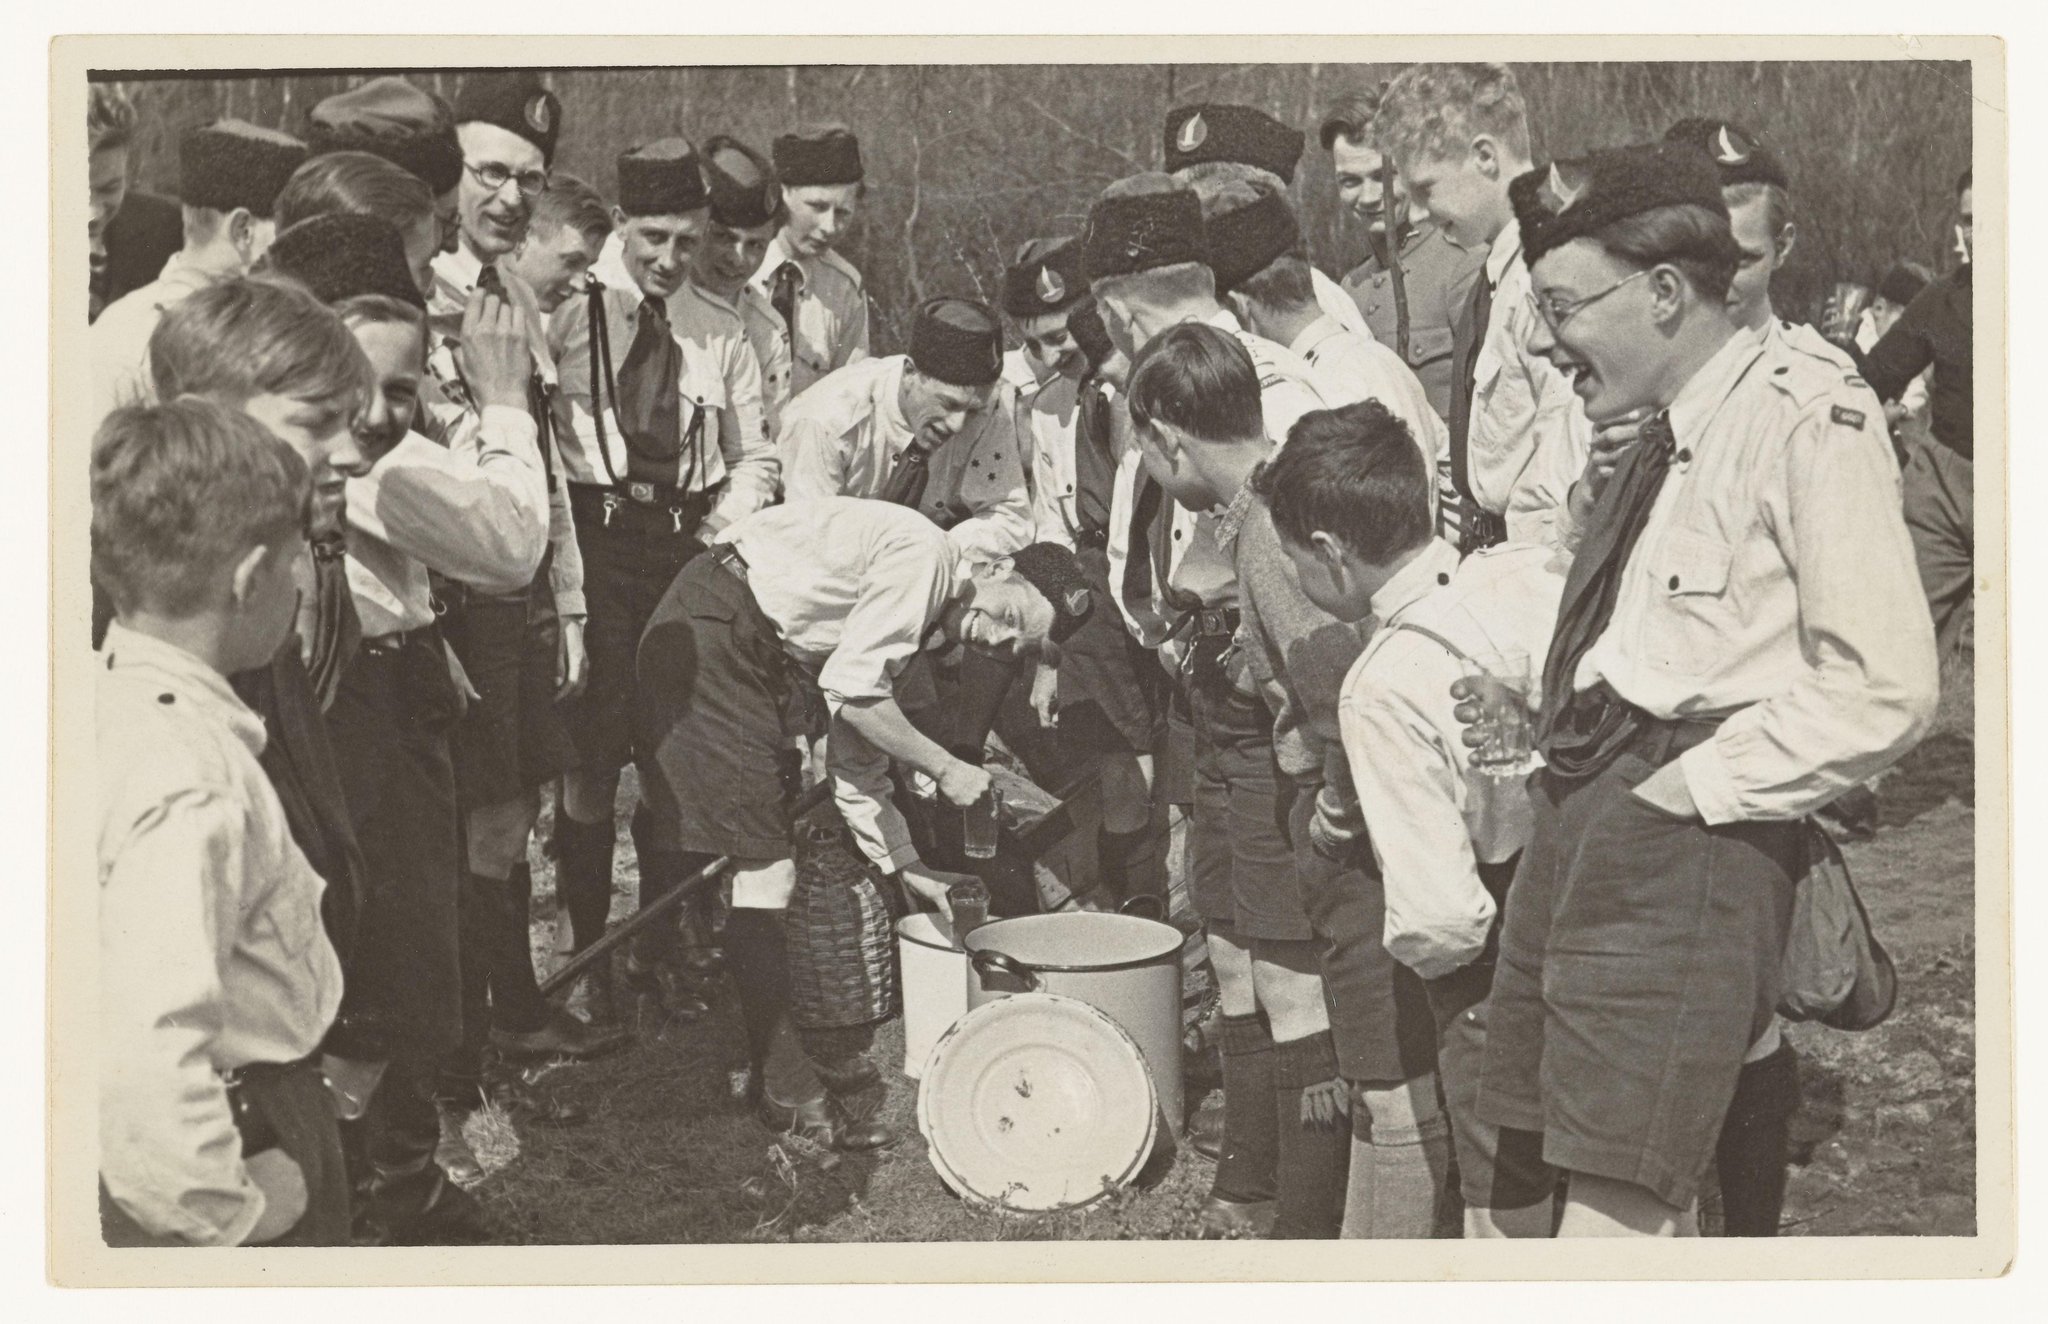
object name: photograph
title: Na afloop van de optocht Jeugdstorm: limonade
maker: j. otto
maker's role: fotograaf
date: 1935-1937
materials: photographic support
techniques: photography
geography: zeist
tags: military parade, pageant, zeist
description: Ergens buiten, vermoedelijk na afloop van de optocht, staan de Jeugdstormers bij elkaar rond een pan en een emmer waar iets te drinken uit geschept wordt. Erachter staat een mandfles. Sommigen hebben al een glas in hun hand. Bijna allemaal zijn ze in uniform.